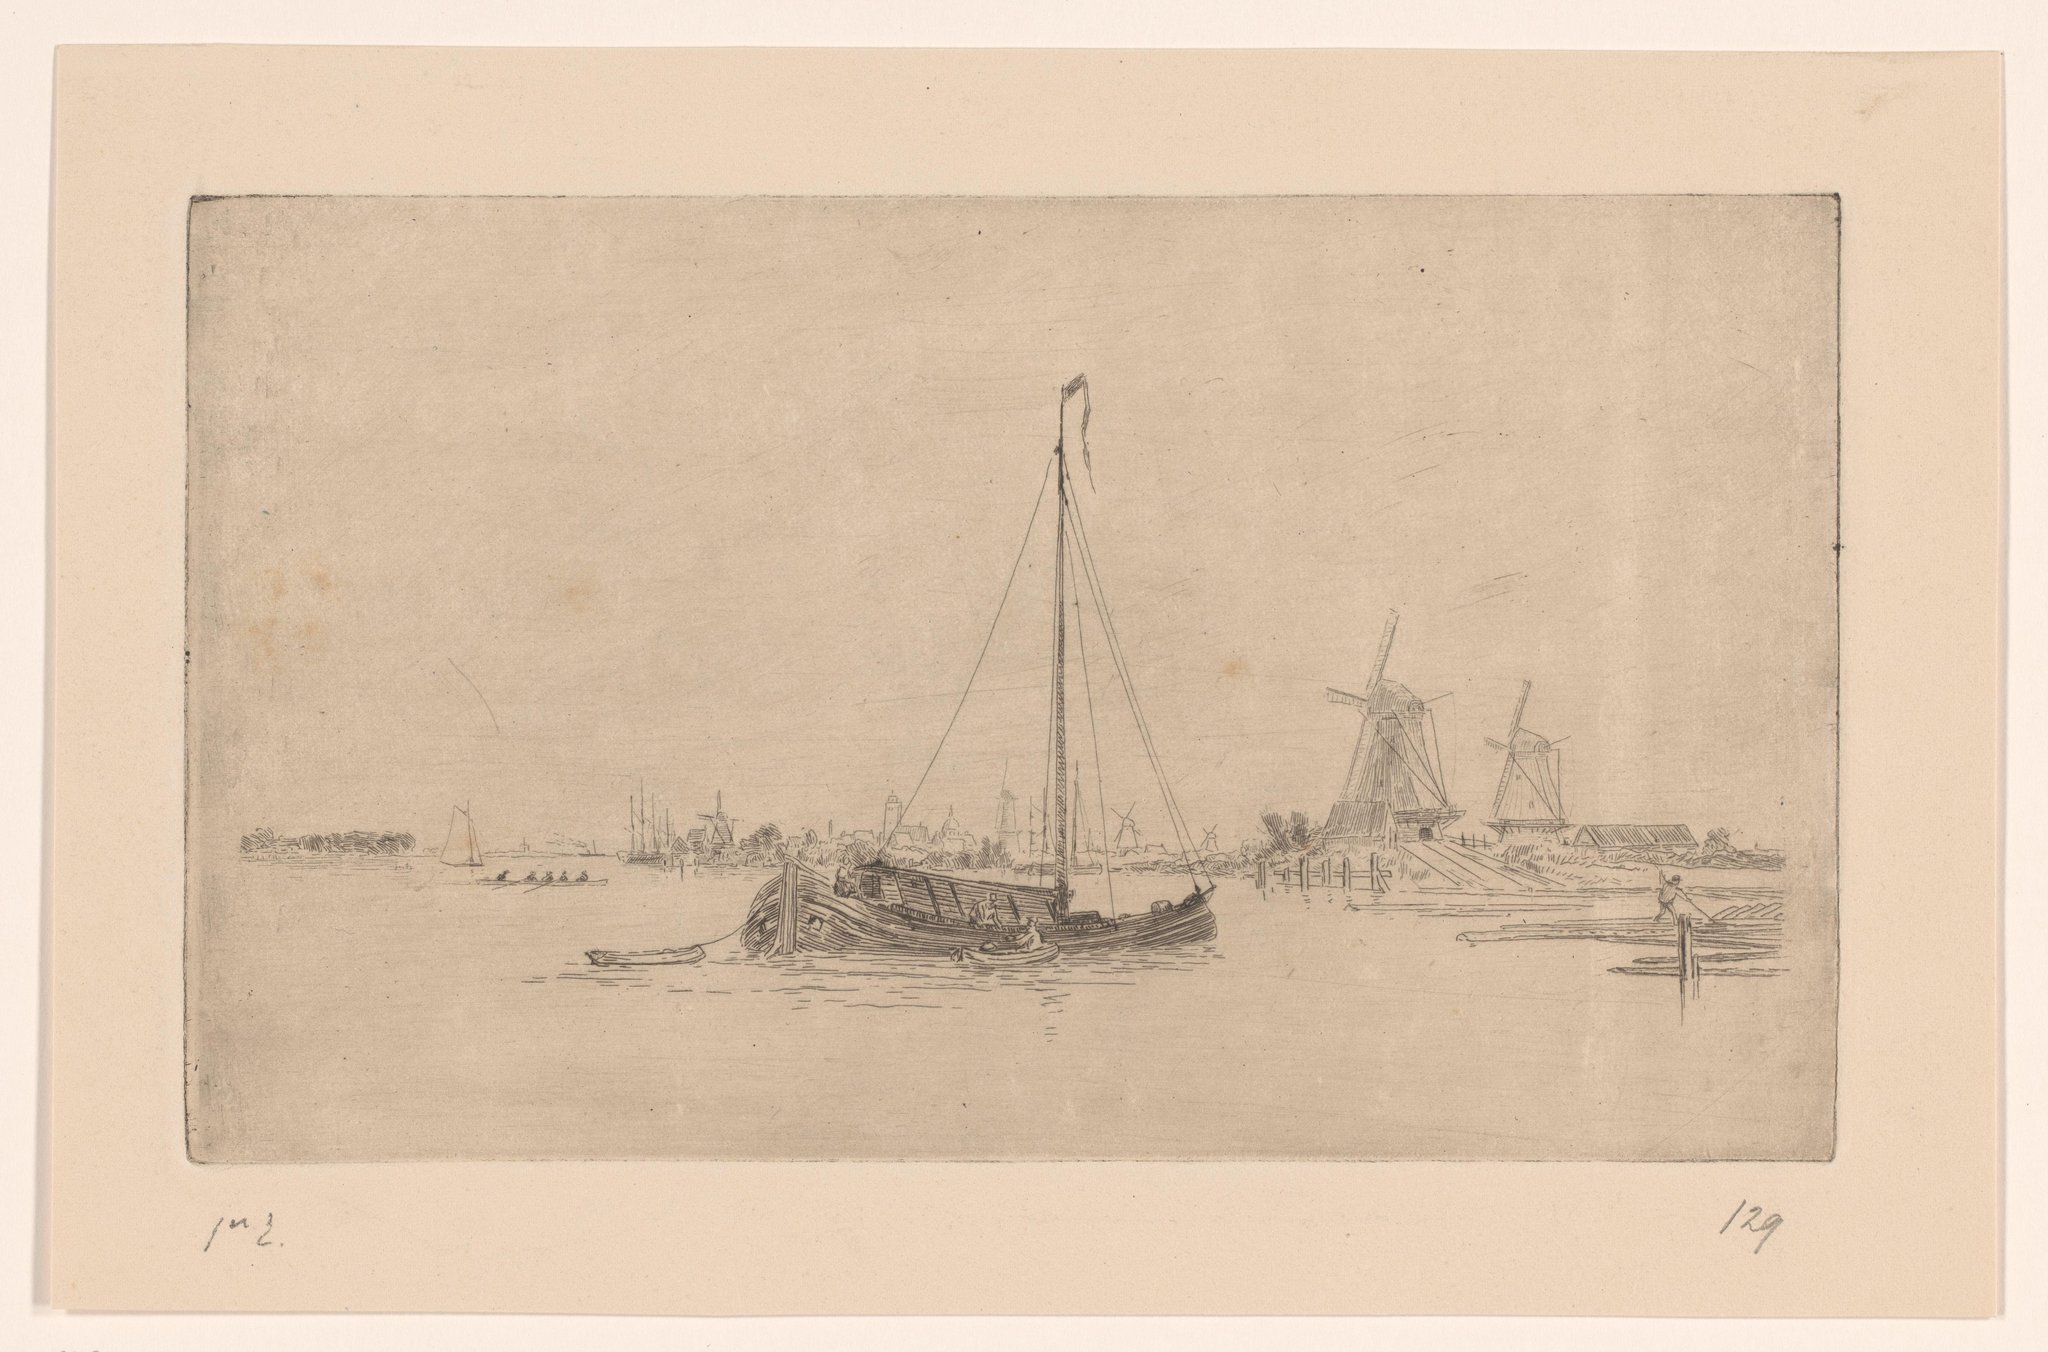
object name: print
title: Zeilboot voor Dordrecht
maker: carel nicolaas storm van s-gravesande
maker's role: draughtsman, print maker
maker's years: 1841-1924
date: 1880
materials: paper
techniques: etching, intaglio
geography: netherlands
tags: sailing-ship, sailing-boat, windmill in landscape, prospect of city, town panorama, silhouette of city (+ city(-scape) with figures, staffage), dordrecht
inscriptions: collector's mark: Lugt 2228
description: Een zeilboot ligt in het water voor Dordrecht. Links op de achtergrond een roeiboot met vijf roeiers.